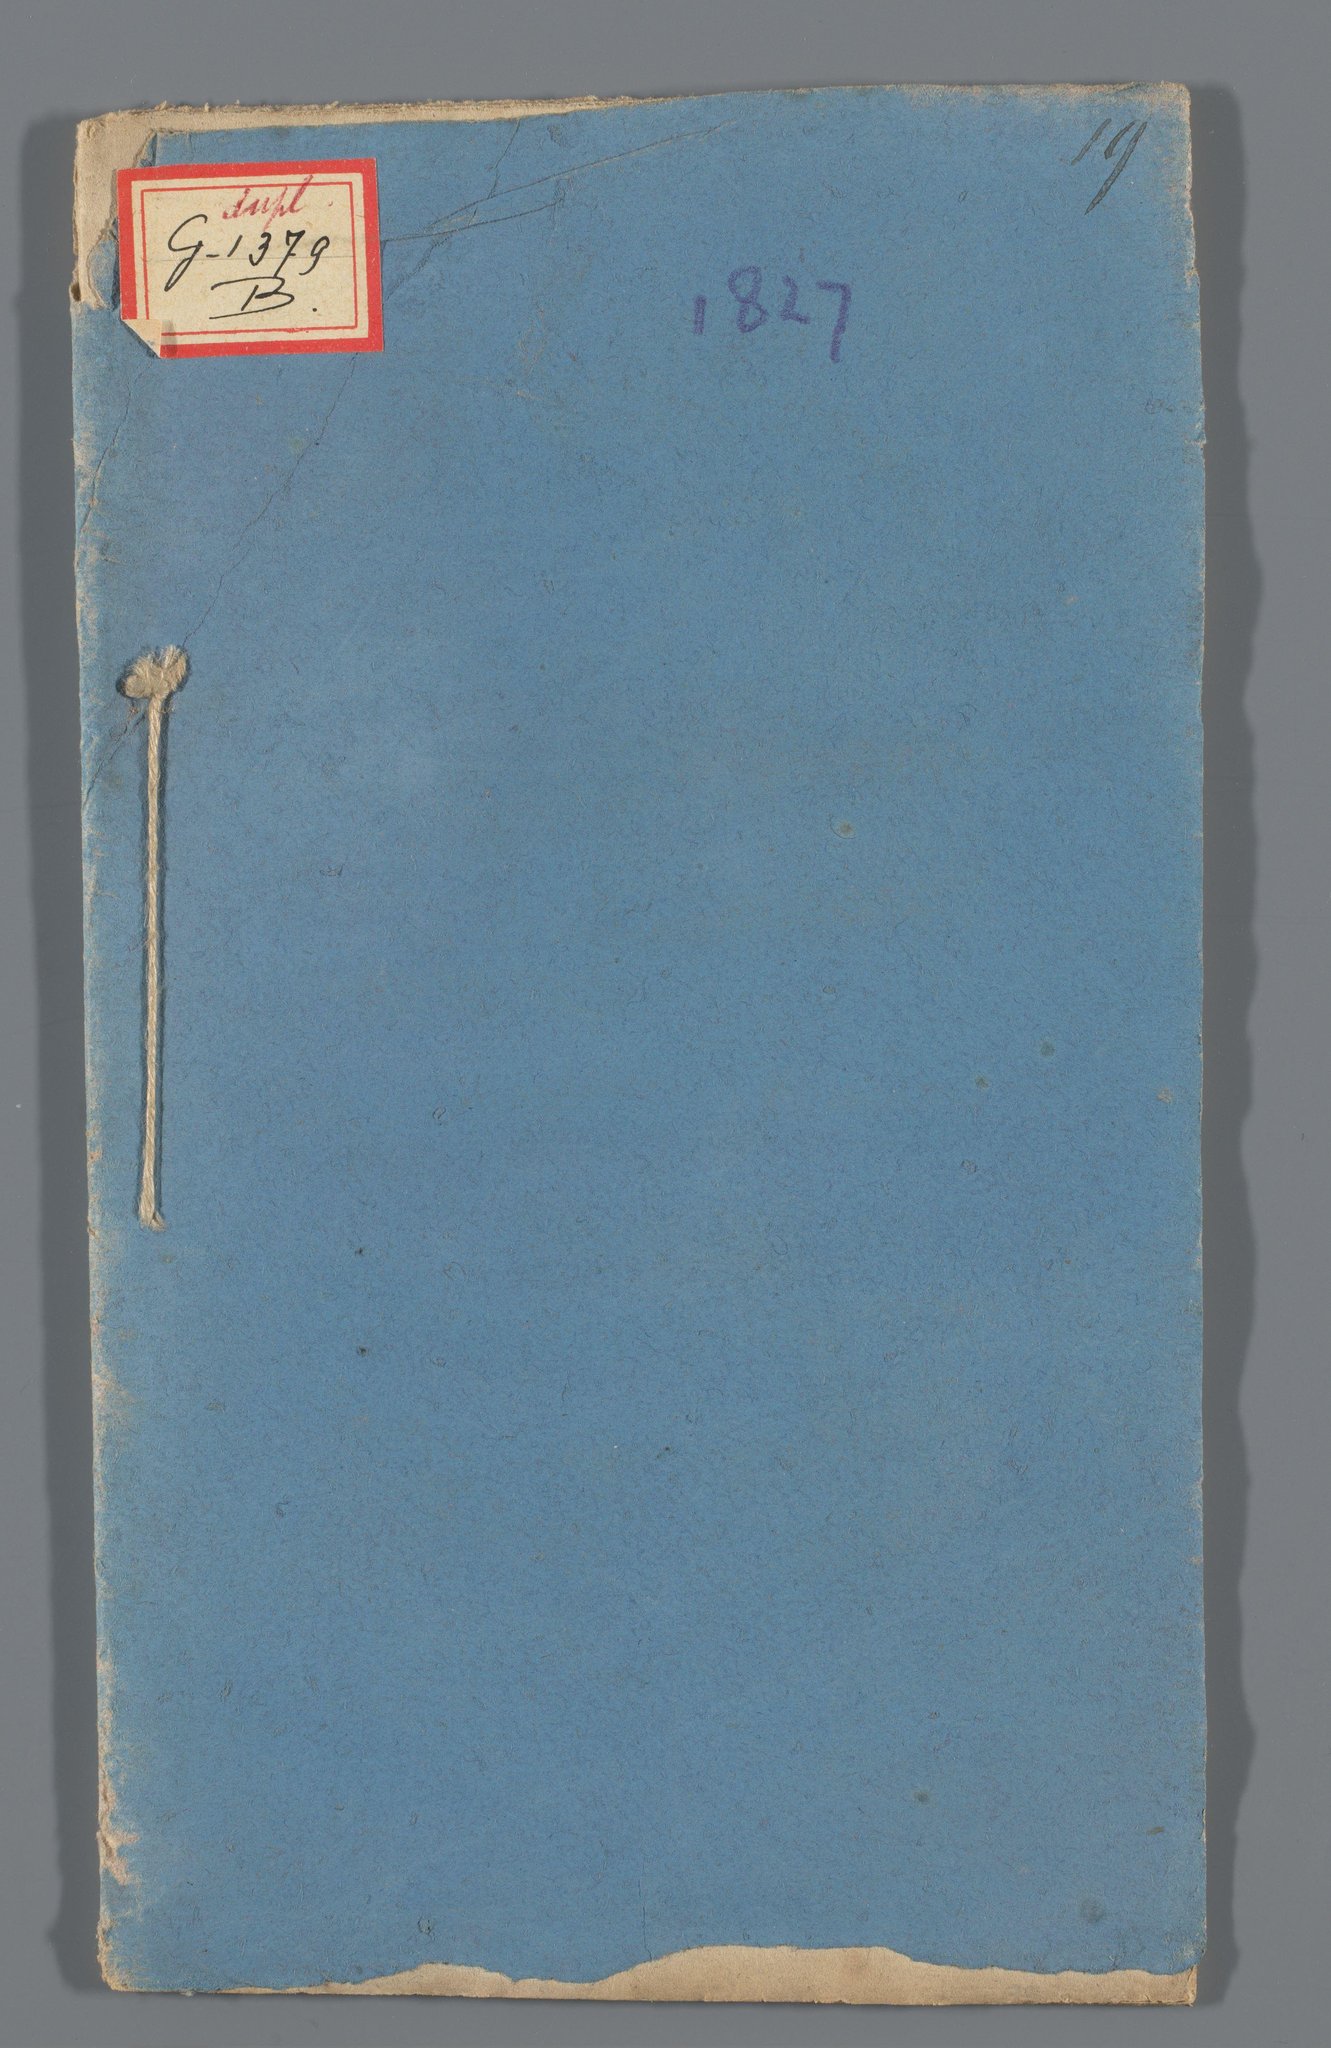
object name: brochure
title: Algemeen verslag van het verhandelde in het algemeene vergadering van hoofdbestuur (..) over Fonds ter aanmoediging en ondersteuning van gewapenden dienst in de Nederlanden.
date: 1827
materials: paper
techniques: printing, sewing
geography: amsterdam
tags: netherlands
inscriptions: date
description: 30 genummerde pp in blauwe papieren omslag, verslag van vergadering. Gedateerd; p.1.